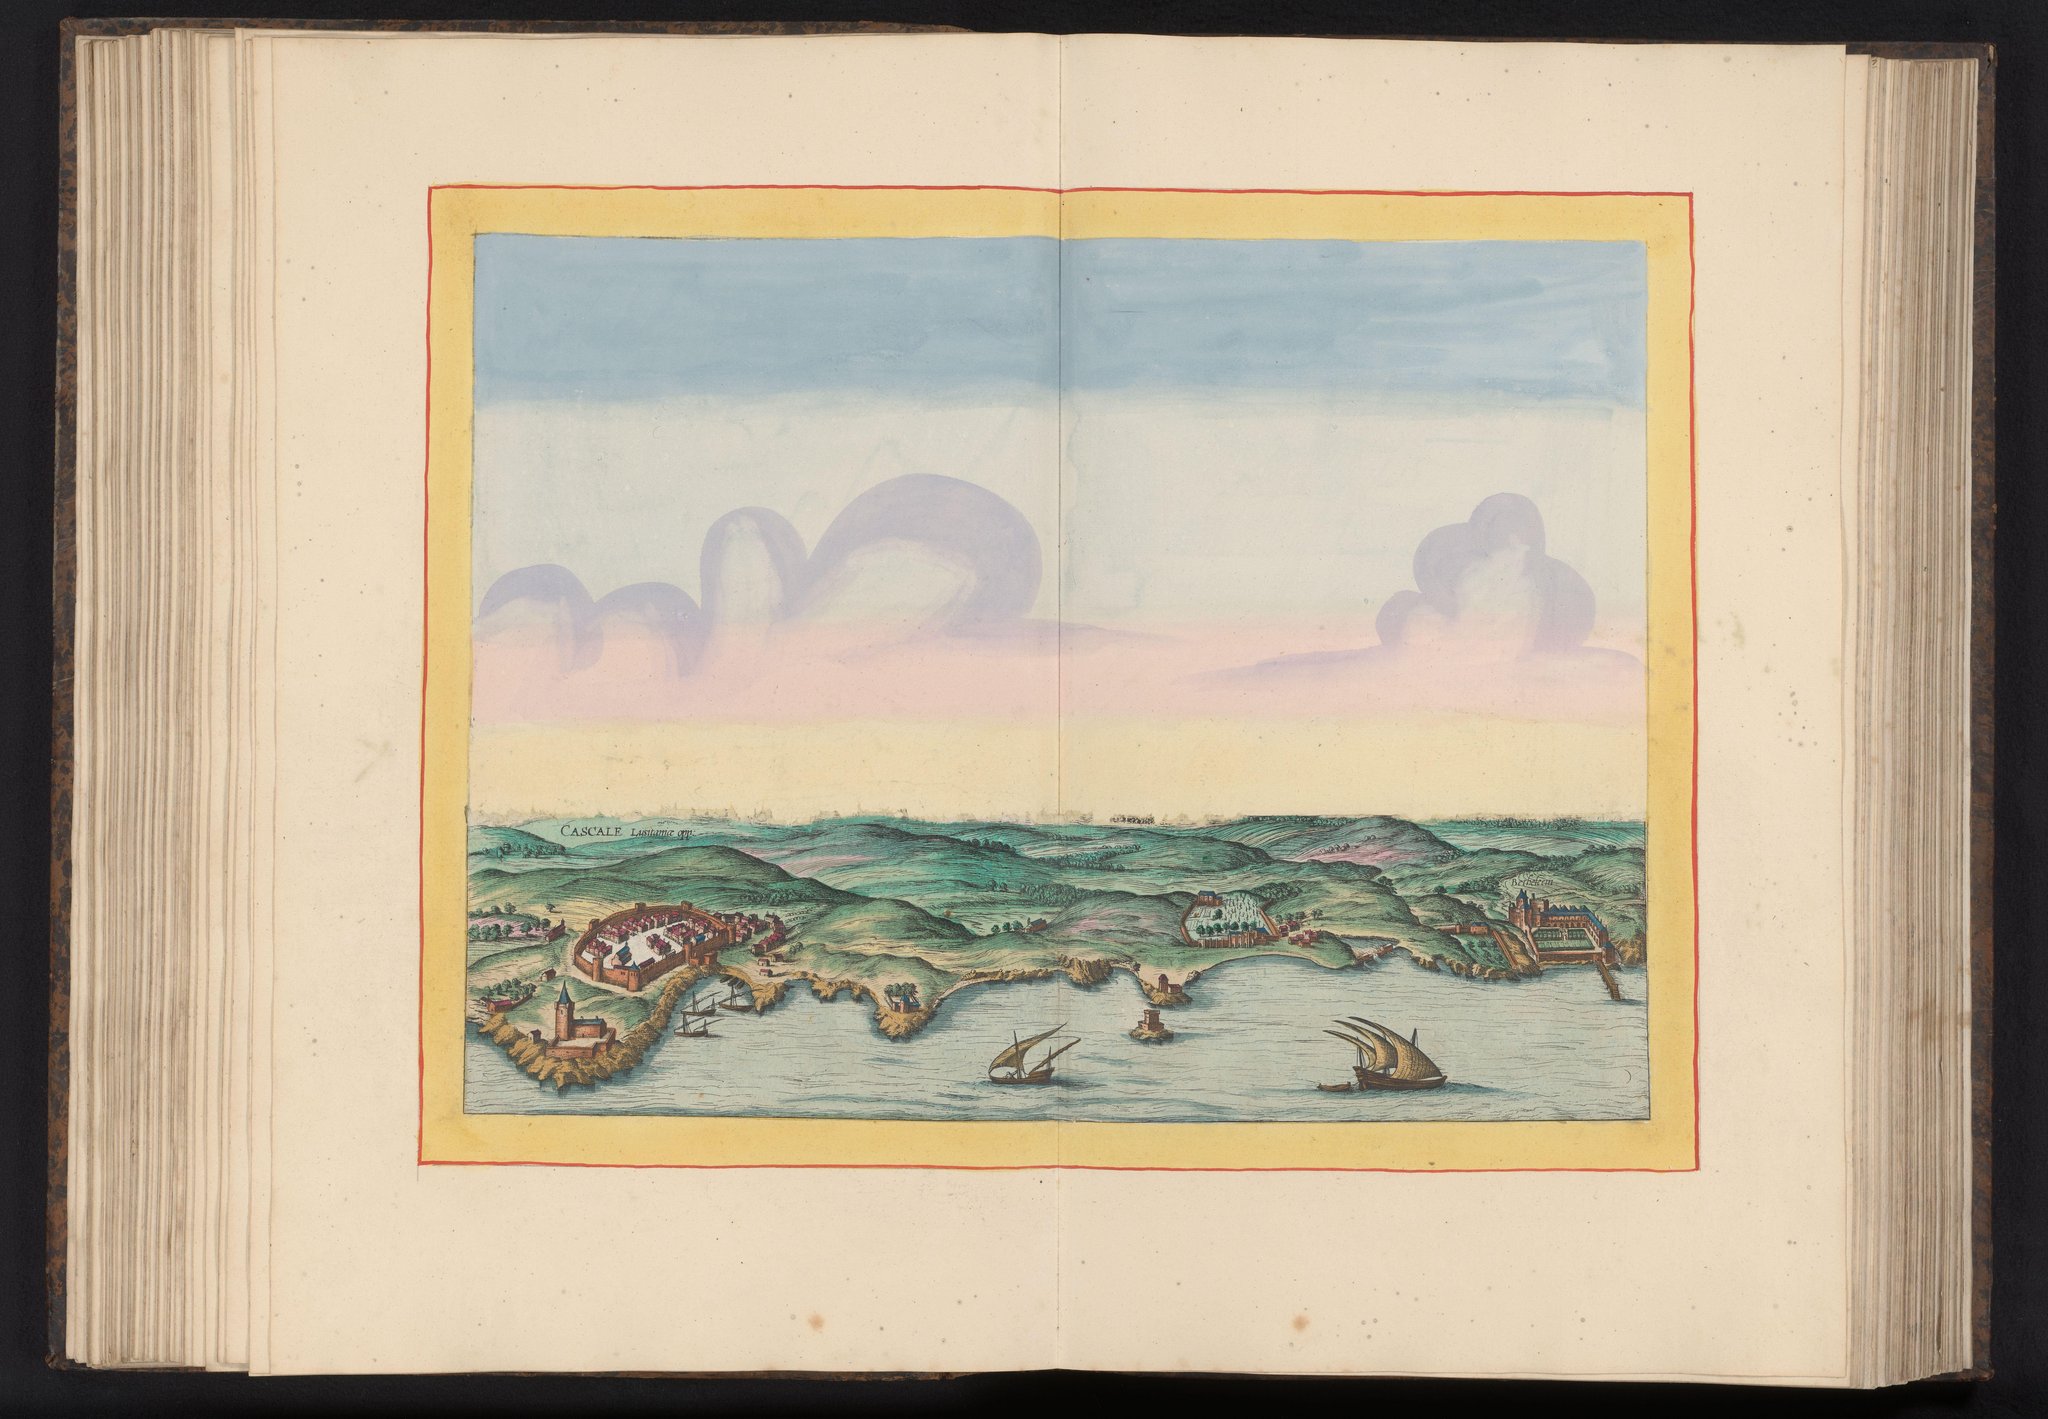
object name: print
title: Kust bij Lissabon met de plaatsen Cascais en Bélem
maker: anna beeck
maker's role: publisher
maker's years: 1657-1717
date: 1572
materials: paper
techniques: engraving, etching, hand coloring, letterpress printing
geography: the hague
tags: coast, prospect of city, town panorama, silhouette of city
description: Prent origineel vervaardigd als boekillustratie voor: Georg Braun en Frans Hogenberg. Civitates Orbis Terrarum, 6 delen. Keulen: 1572-1617. De prent werd voor het eerst gepubliceerd in deel 1: Civitatis orbis terrarum (liber primus), 1572. De prent is langs de bovenrand van de heuvels afgescheurd. Het bovenste gedeelte met de lucht is hoger opgeplakt, zodat de lucht hoger is geworden en het formaat van de voorstelling past bij de andere groot formaatvoorstellingen in het album.